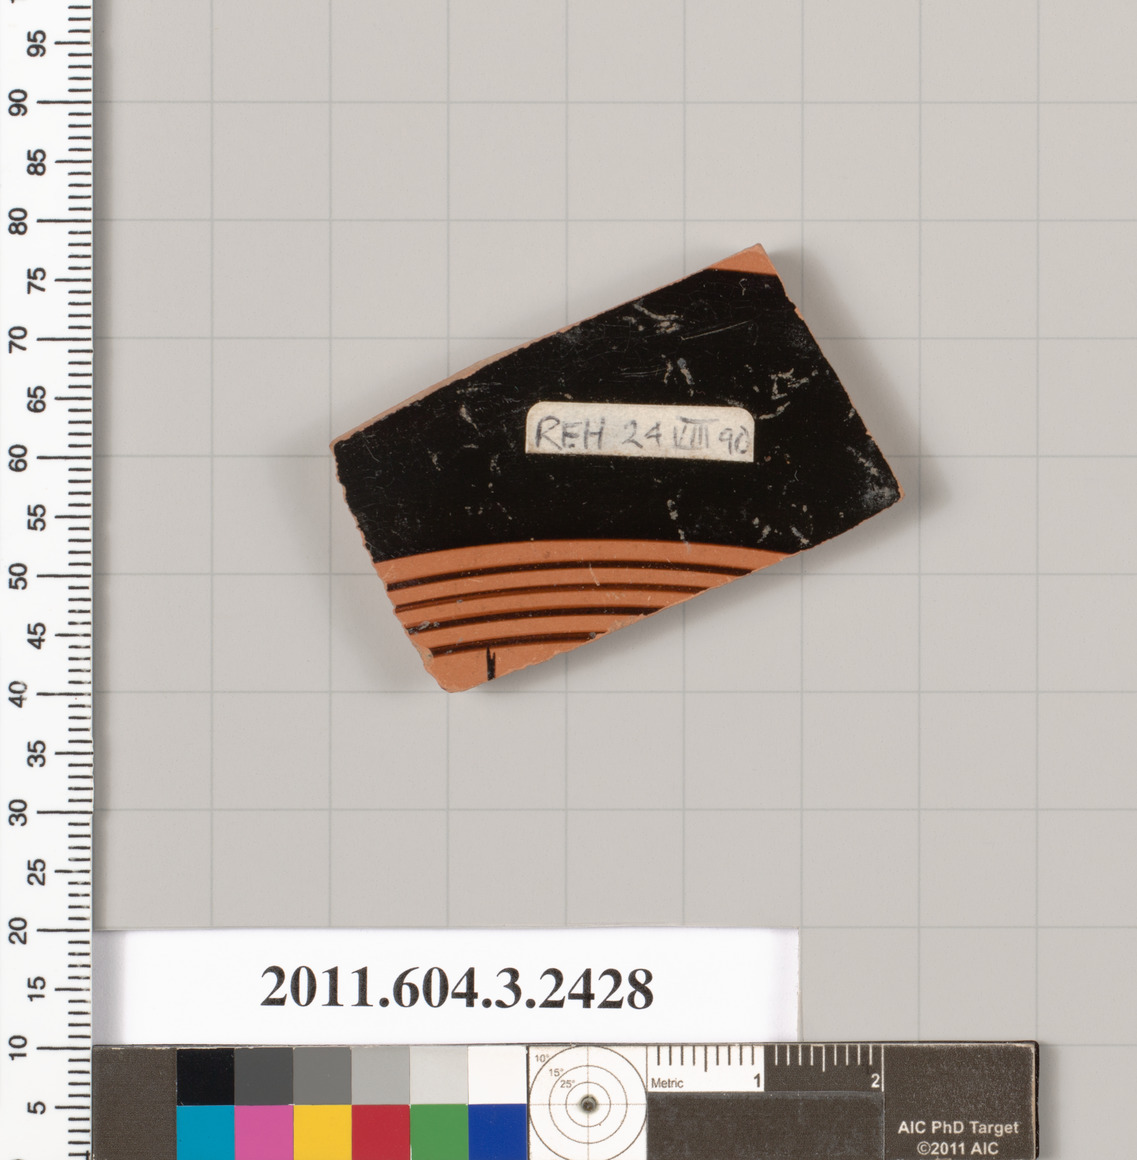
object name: kylix fragment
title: Terracotta fragment of a kylix: eye-cup (drinking cup)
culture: greek, attic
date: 530-520 BCE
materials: terracotta